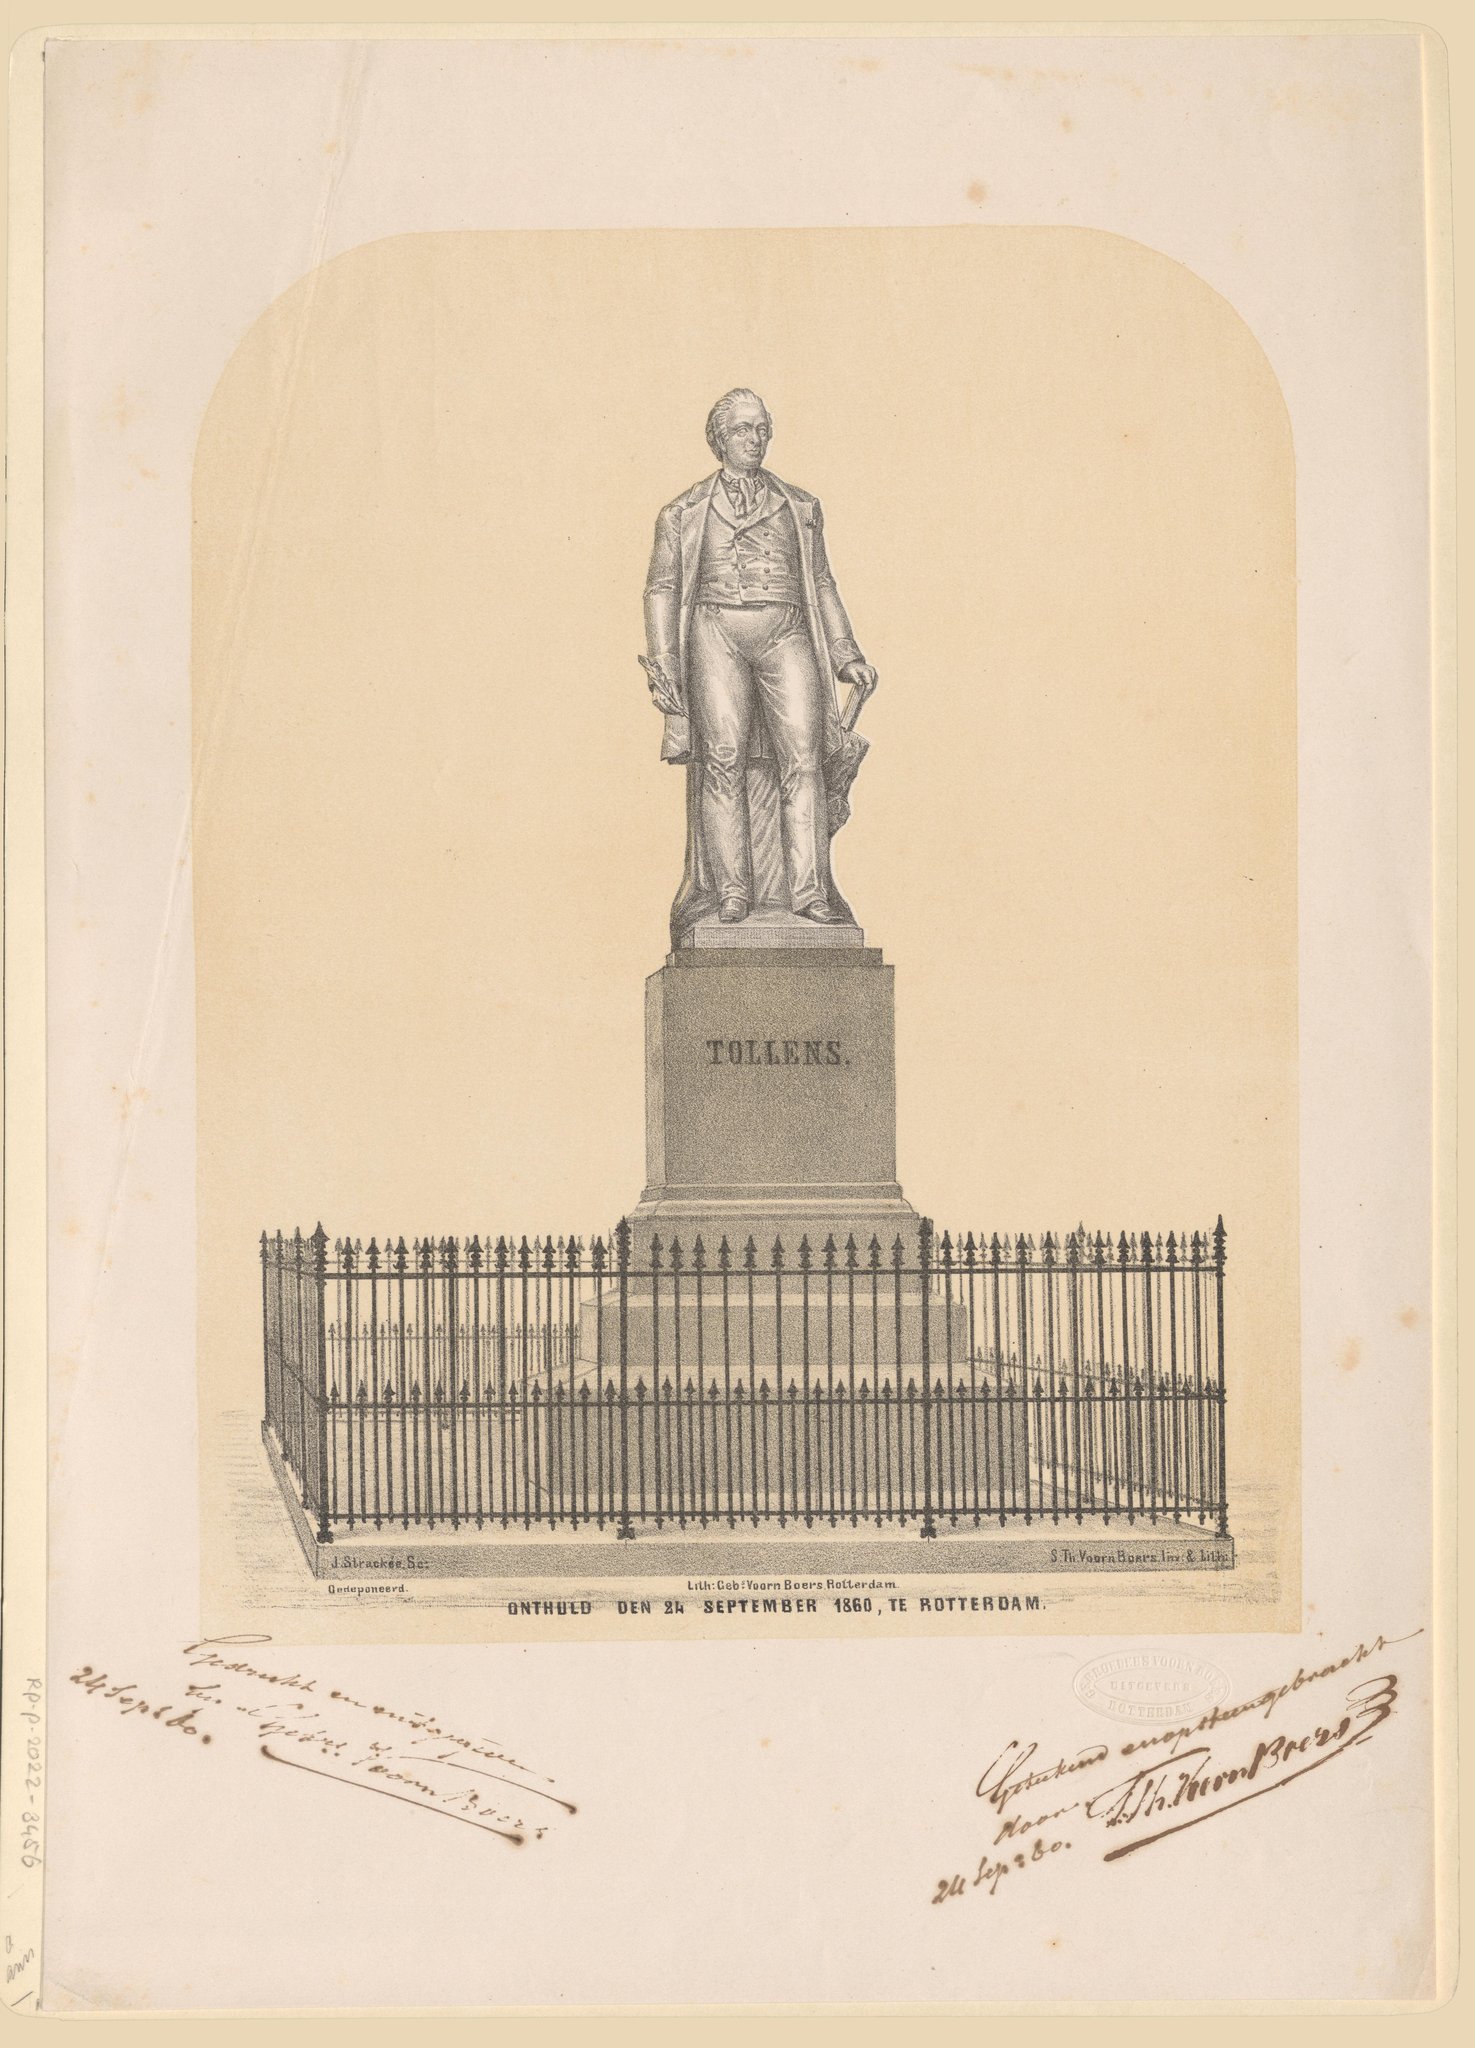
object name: print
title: Standbeeld van Hendrik Tollens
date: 1860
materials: paper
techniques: tone lithography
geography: rotterdam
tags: hendrik tollens, historical persons, monument, statue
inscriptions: : ‘Geteekend en op steen gebracht / door S.T.VoornBoers / 24 sept 60.’, : ‘Gedrukt en uitgegeven / bij Gebr. Voornboers / 24 sept 60.’, : ‘Gedeponeerd.’, check stamp: ‘gebroeders Voorn Boers uitgevers’